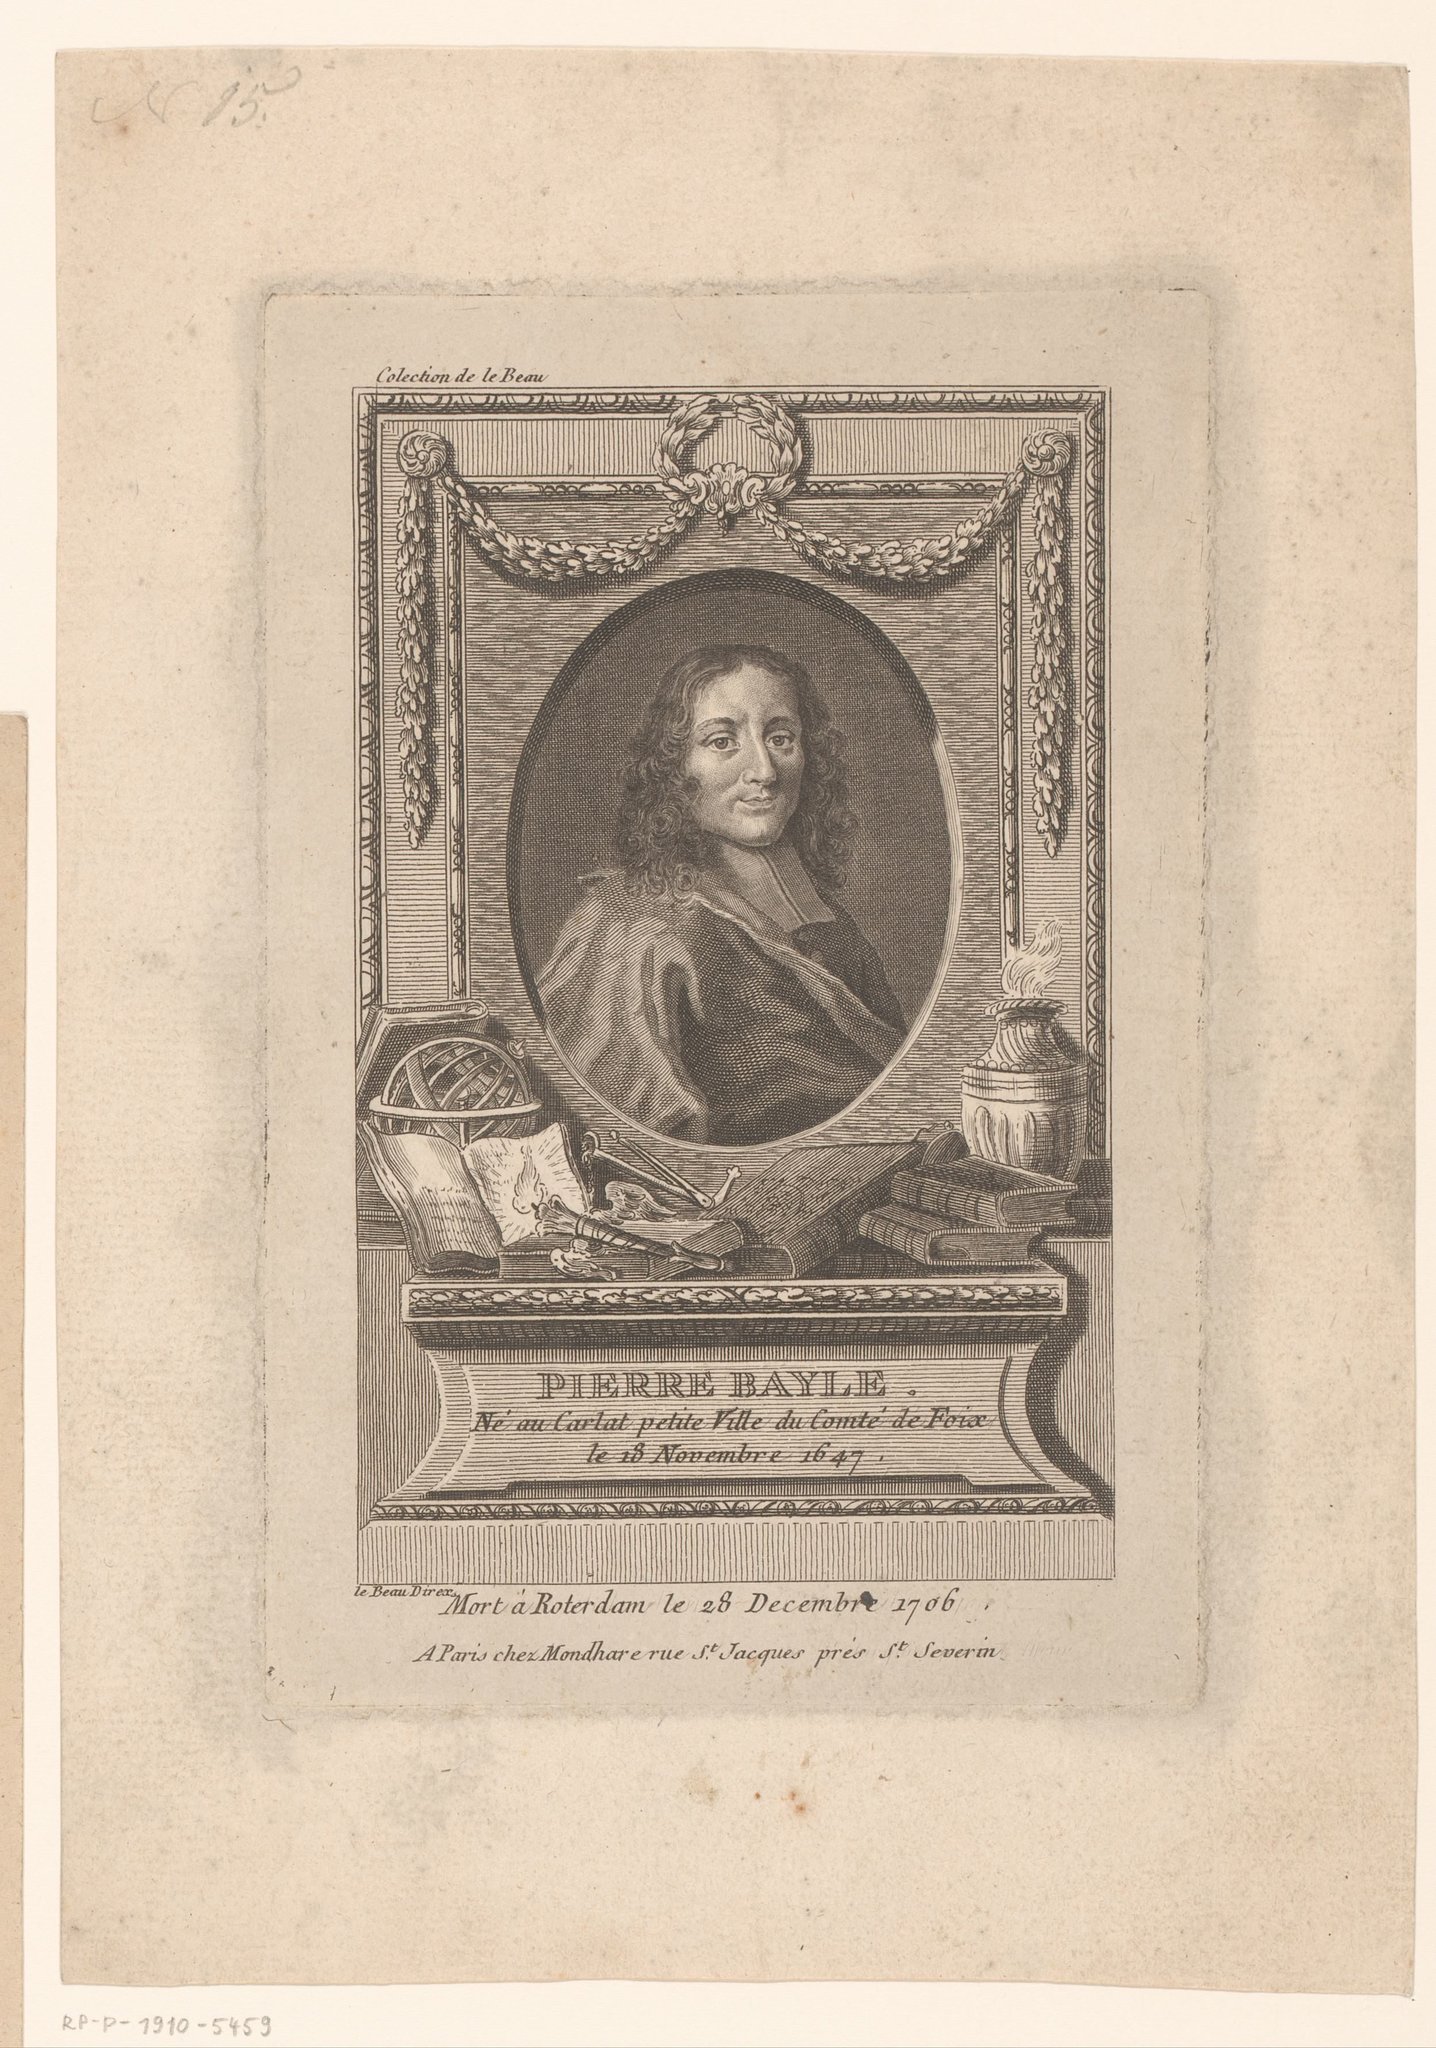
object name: print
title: Portret van Pierre Bayle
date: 1767-1806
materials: paper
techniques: engraving, etching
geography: france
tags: scholar, philosopher, ornament ~ medallion, historical persons, portrait of a writer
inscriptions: collector's mark: Lugt 2228